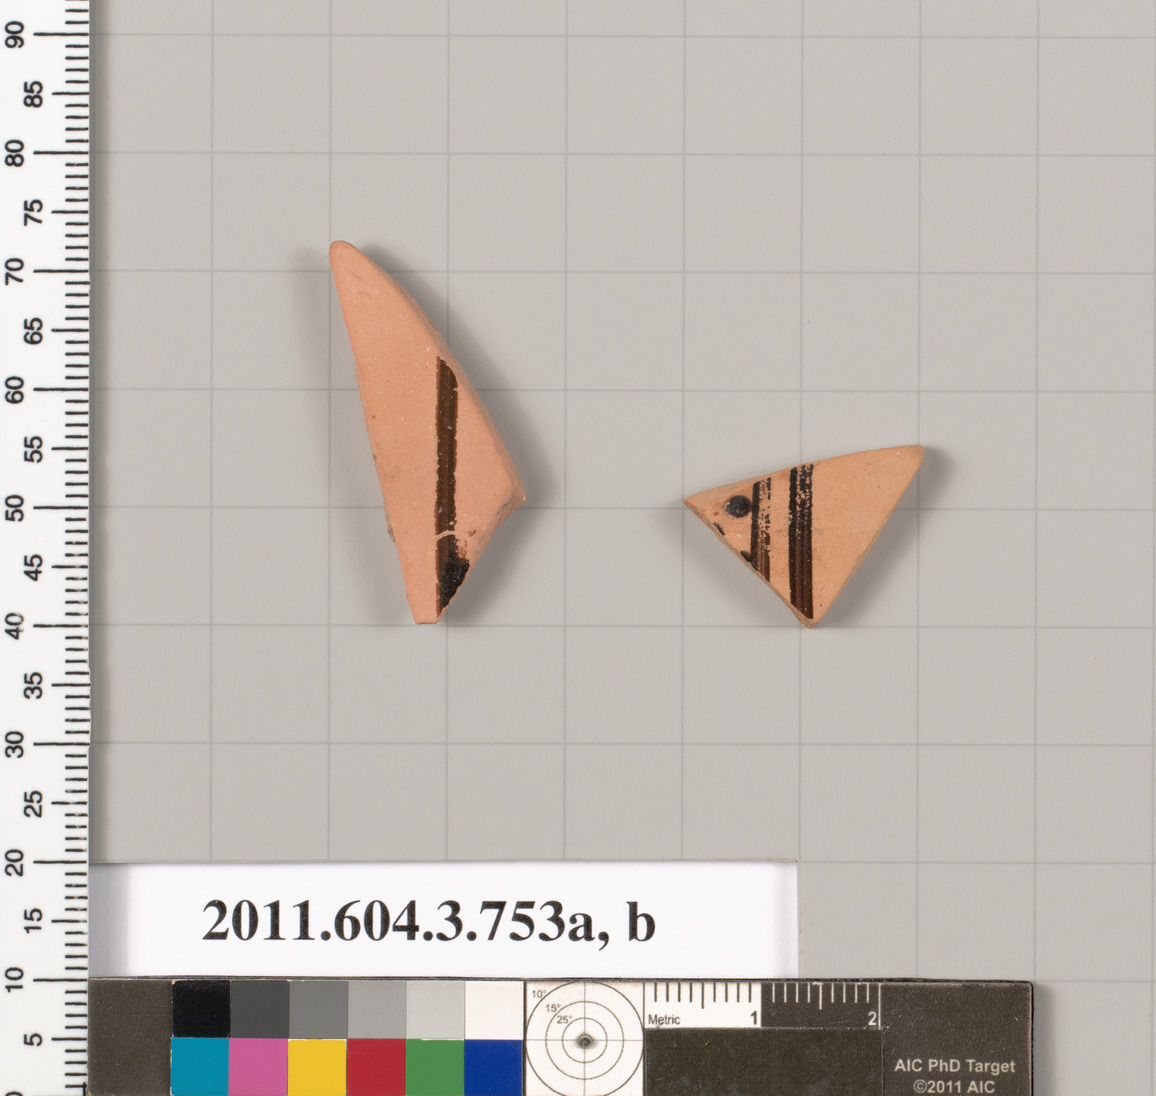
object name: neck amphora, tyrrhenian fragment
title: Terracotta fragments of a neck-amphora (jar)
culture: greek, attic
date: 575-551 BCE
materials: terracotta